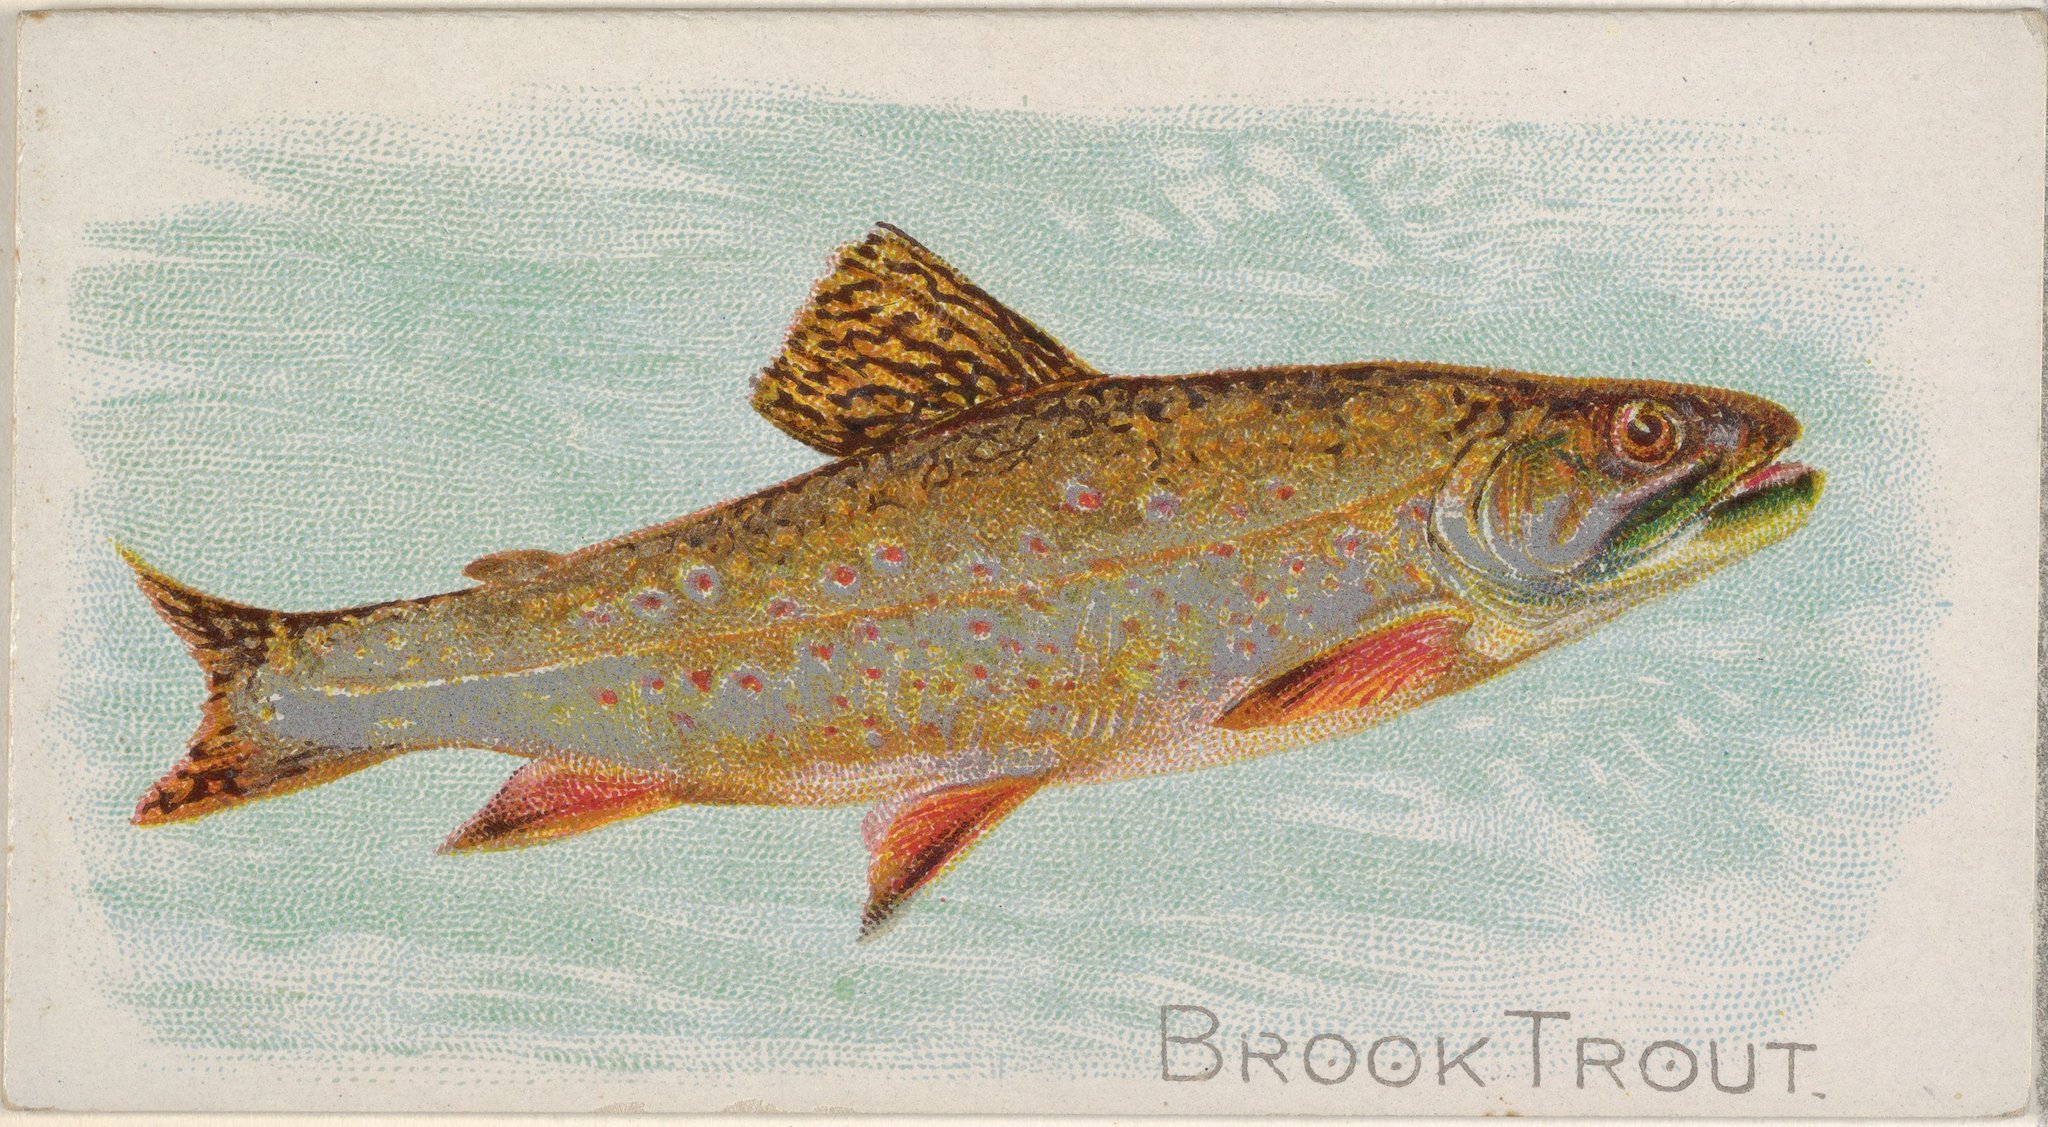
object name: print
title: Brook Trout, from the Fish from American Waters series (N8) for Allen & Ginter Cigarettes Brands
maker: allen & ginter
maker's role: publisher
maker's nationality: american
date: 1889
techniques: color lithograph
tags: fish